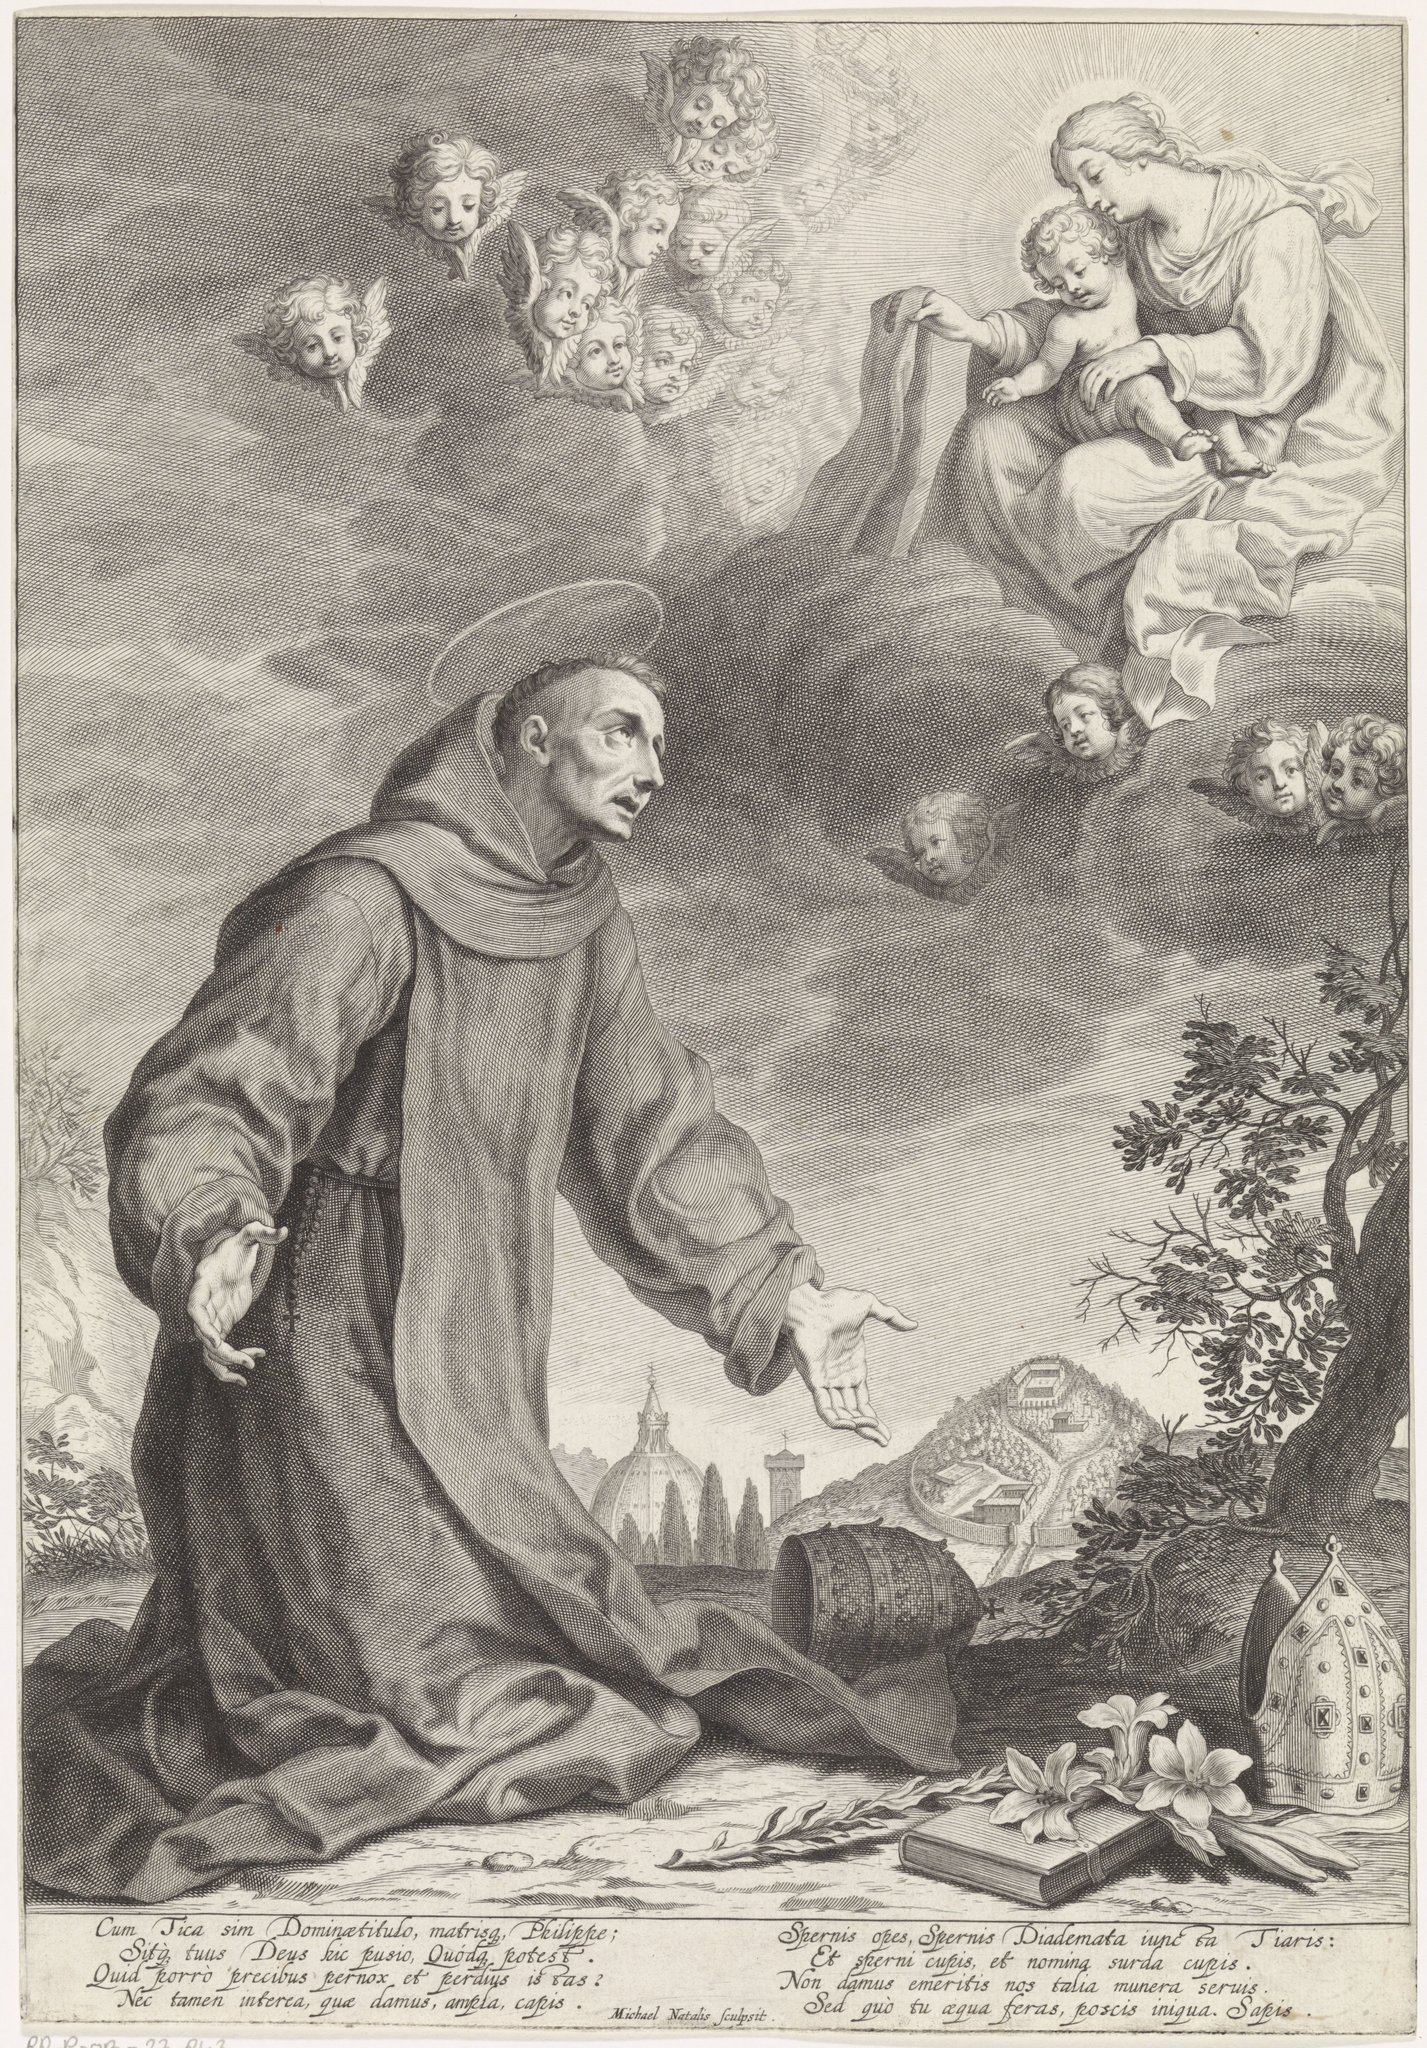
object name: print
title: De heilige Philippus Benitius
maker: michel natalis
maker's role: print maker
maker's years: 1610-1668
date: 1620-1668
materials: paper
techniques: engraving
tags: mary sitting or enthroned, the christ-child in front of her in her lap (or in front of her bosom), prior general of the order of the servites, philip benizzi of florence; possible attributes: book, cross, lily, tiara at his feet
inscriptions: collector's mark: Lugt 240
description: De heilige Philippus Benitius, geknield in een landschap, terwijl hij opkijkt naar de verschijning van Maria met Kind op de wolken. Philippus Benitius is gekleed in het ordekleed van de servieten. Voor hem op de grond liggen een pauselijke tiara, een lelie, een boek en een mijter. Op de achtergrond in het landschap de Dom van Florence. Onderaan in de marge twee vierregelige verzen in het Latijn.